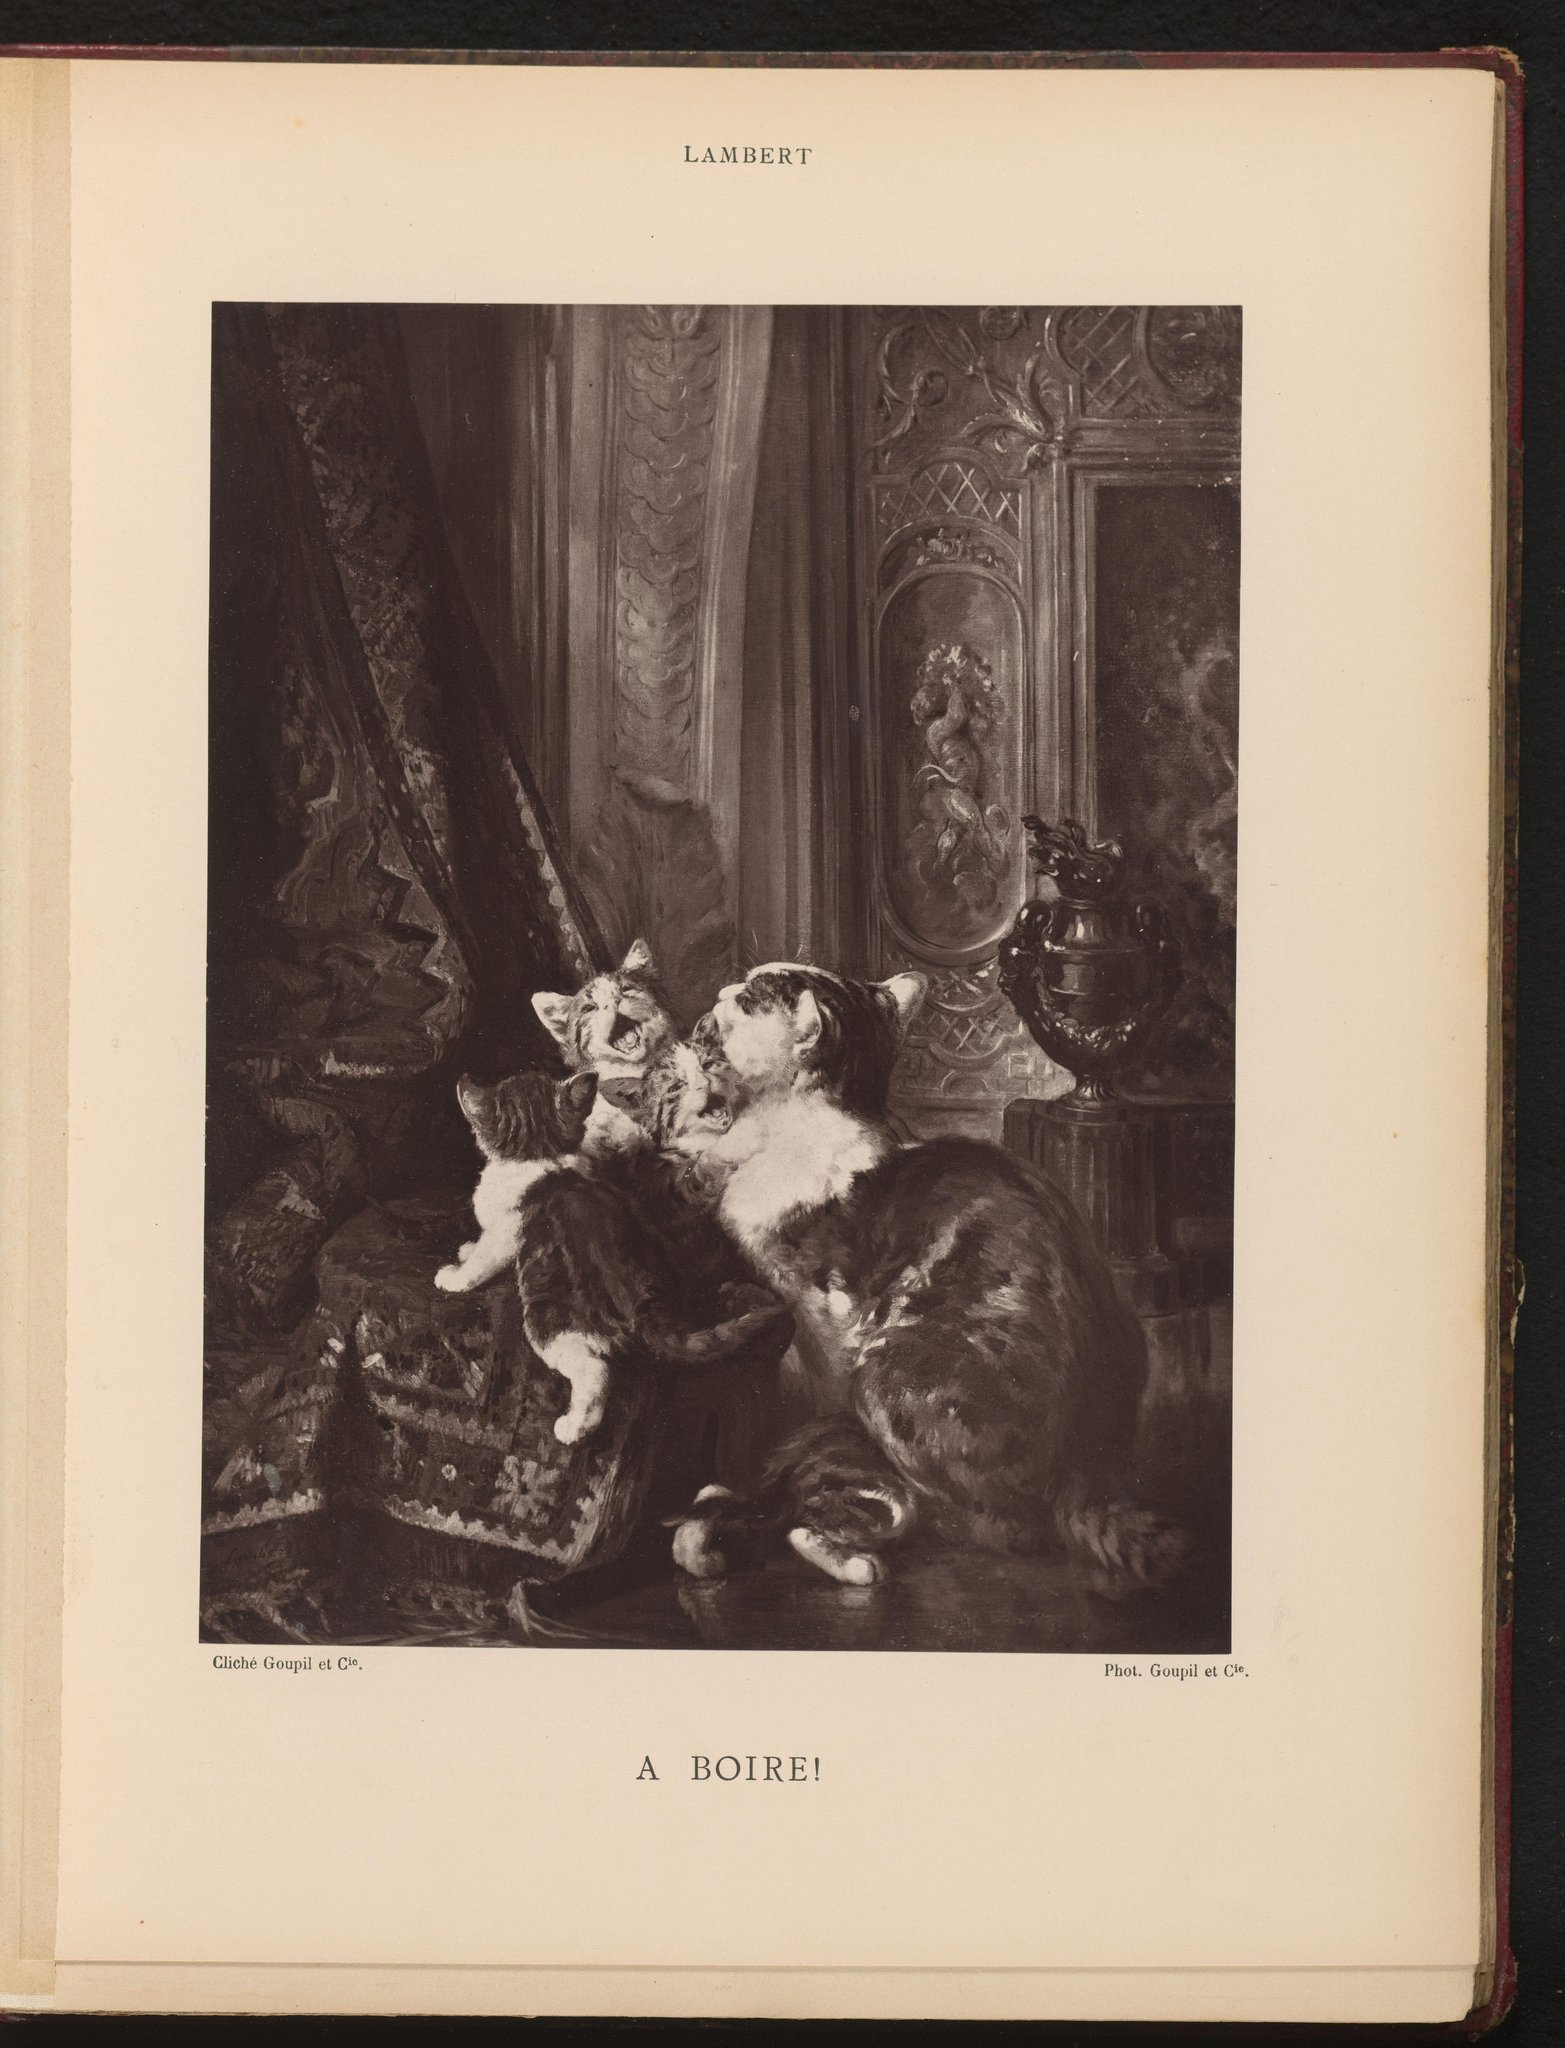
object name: photomechanical print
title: Fotoreproductie van het schilderij 'À boire!' door Eugène Lambert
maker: louis-eugène lambert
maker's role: painter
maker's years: 1825-1900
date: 1876-1881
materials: paper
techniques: woodburytype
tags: cat